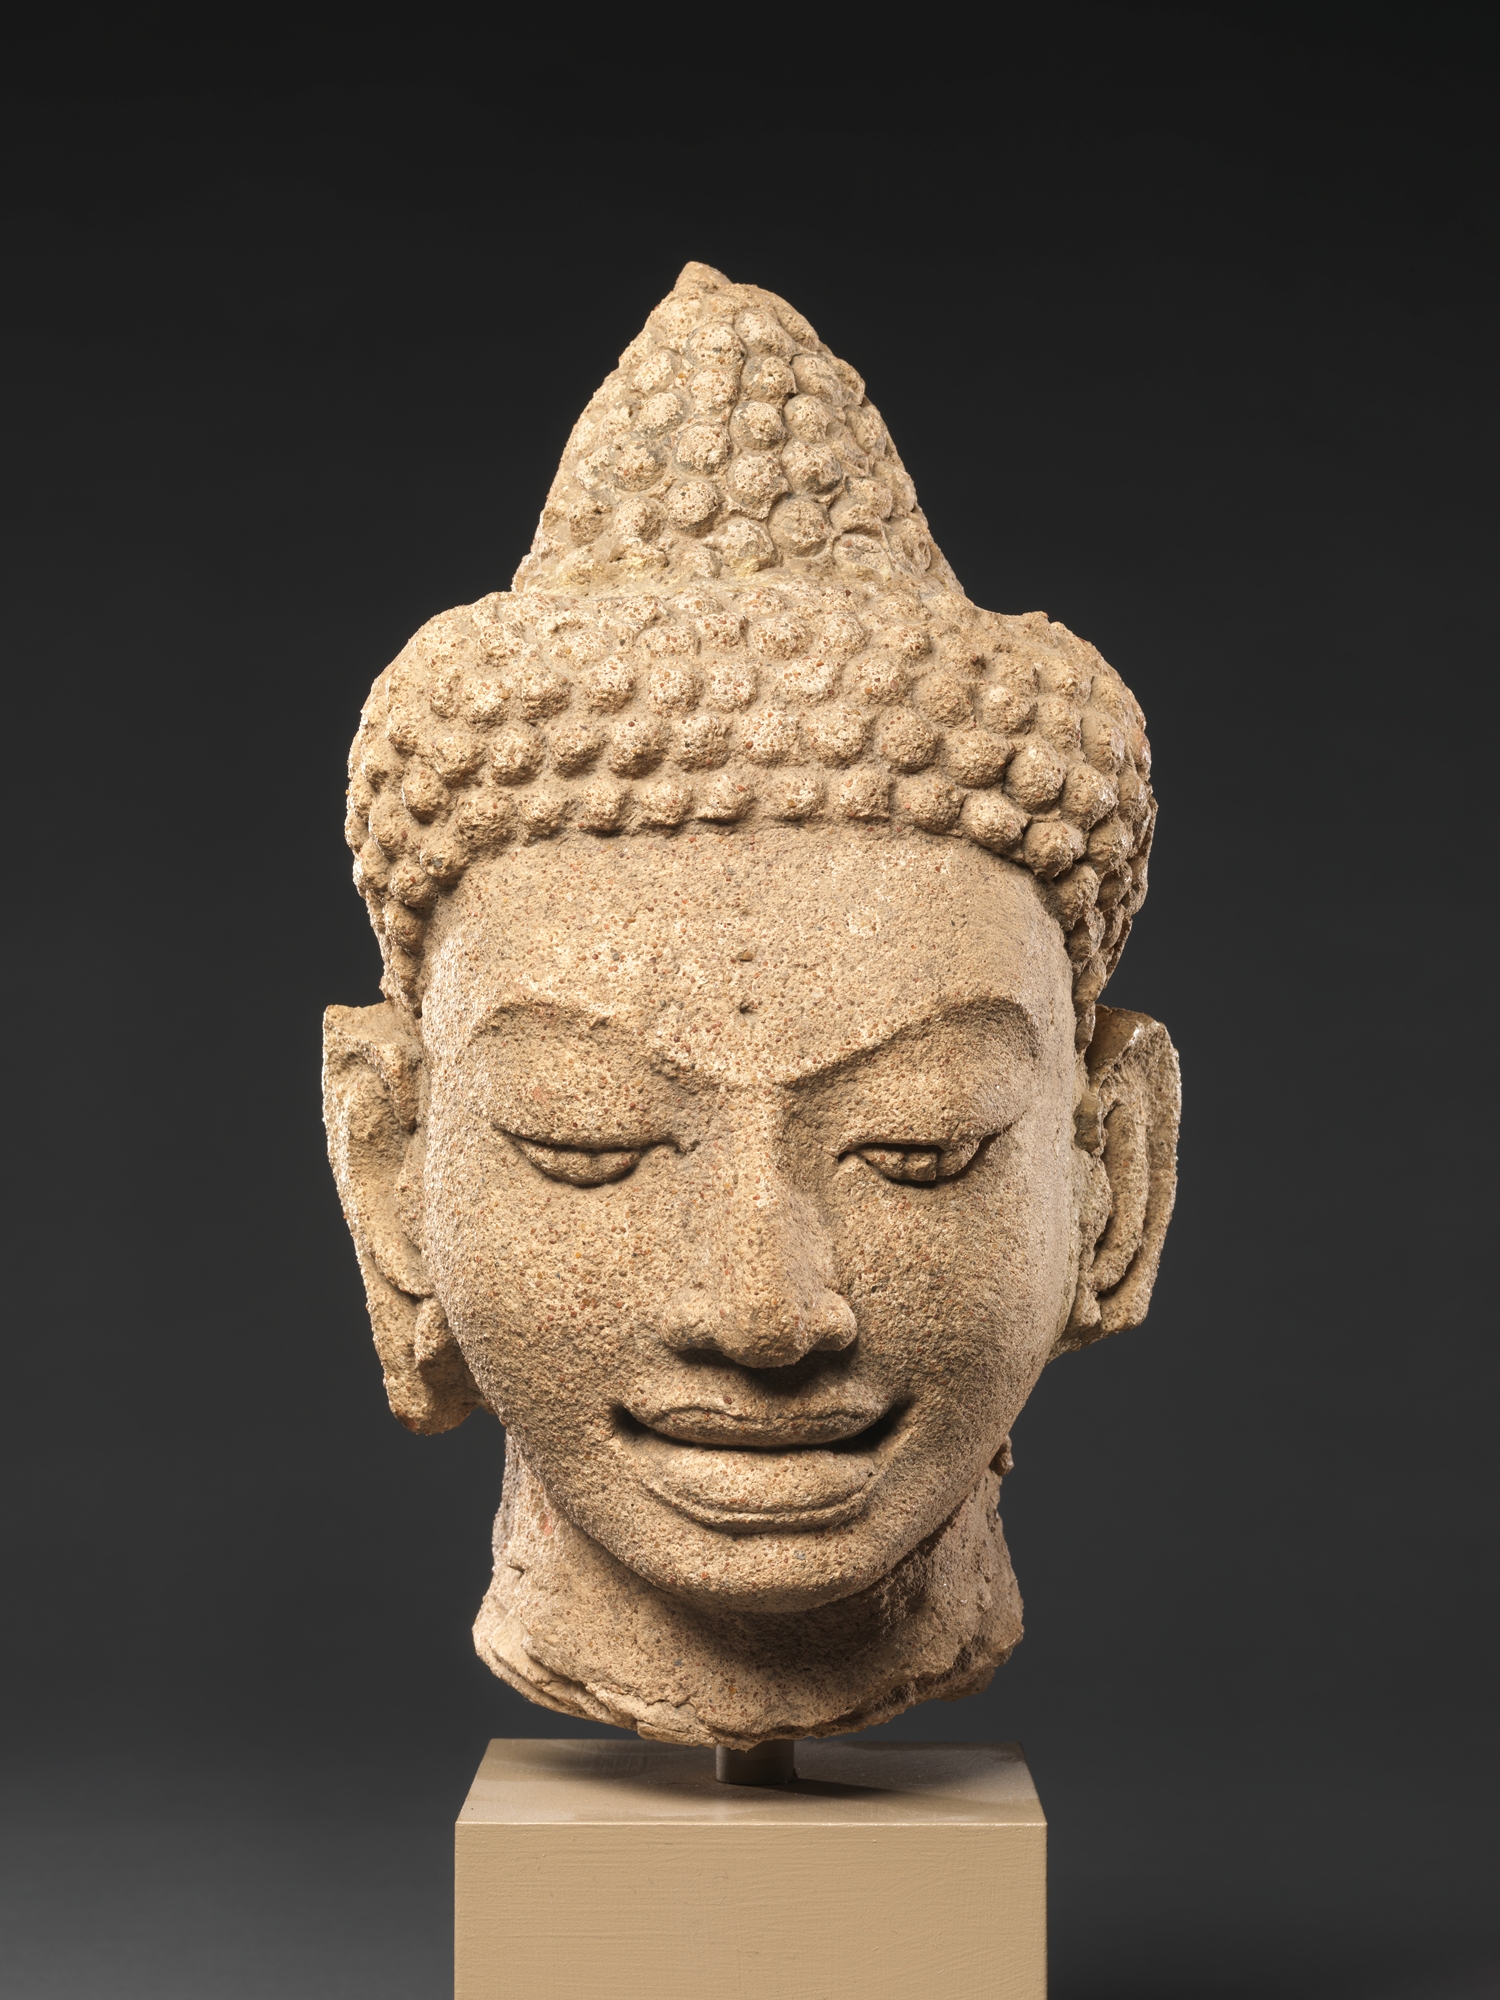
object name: head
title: Head of Buddha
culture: thai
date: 801-900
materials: plaster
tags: heads,buddhism,buddha